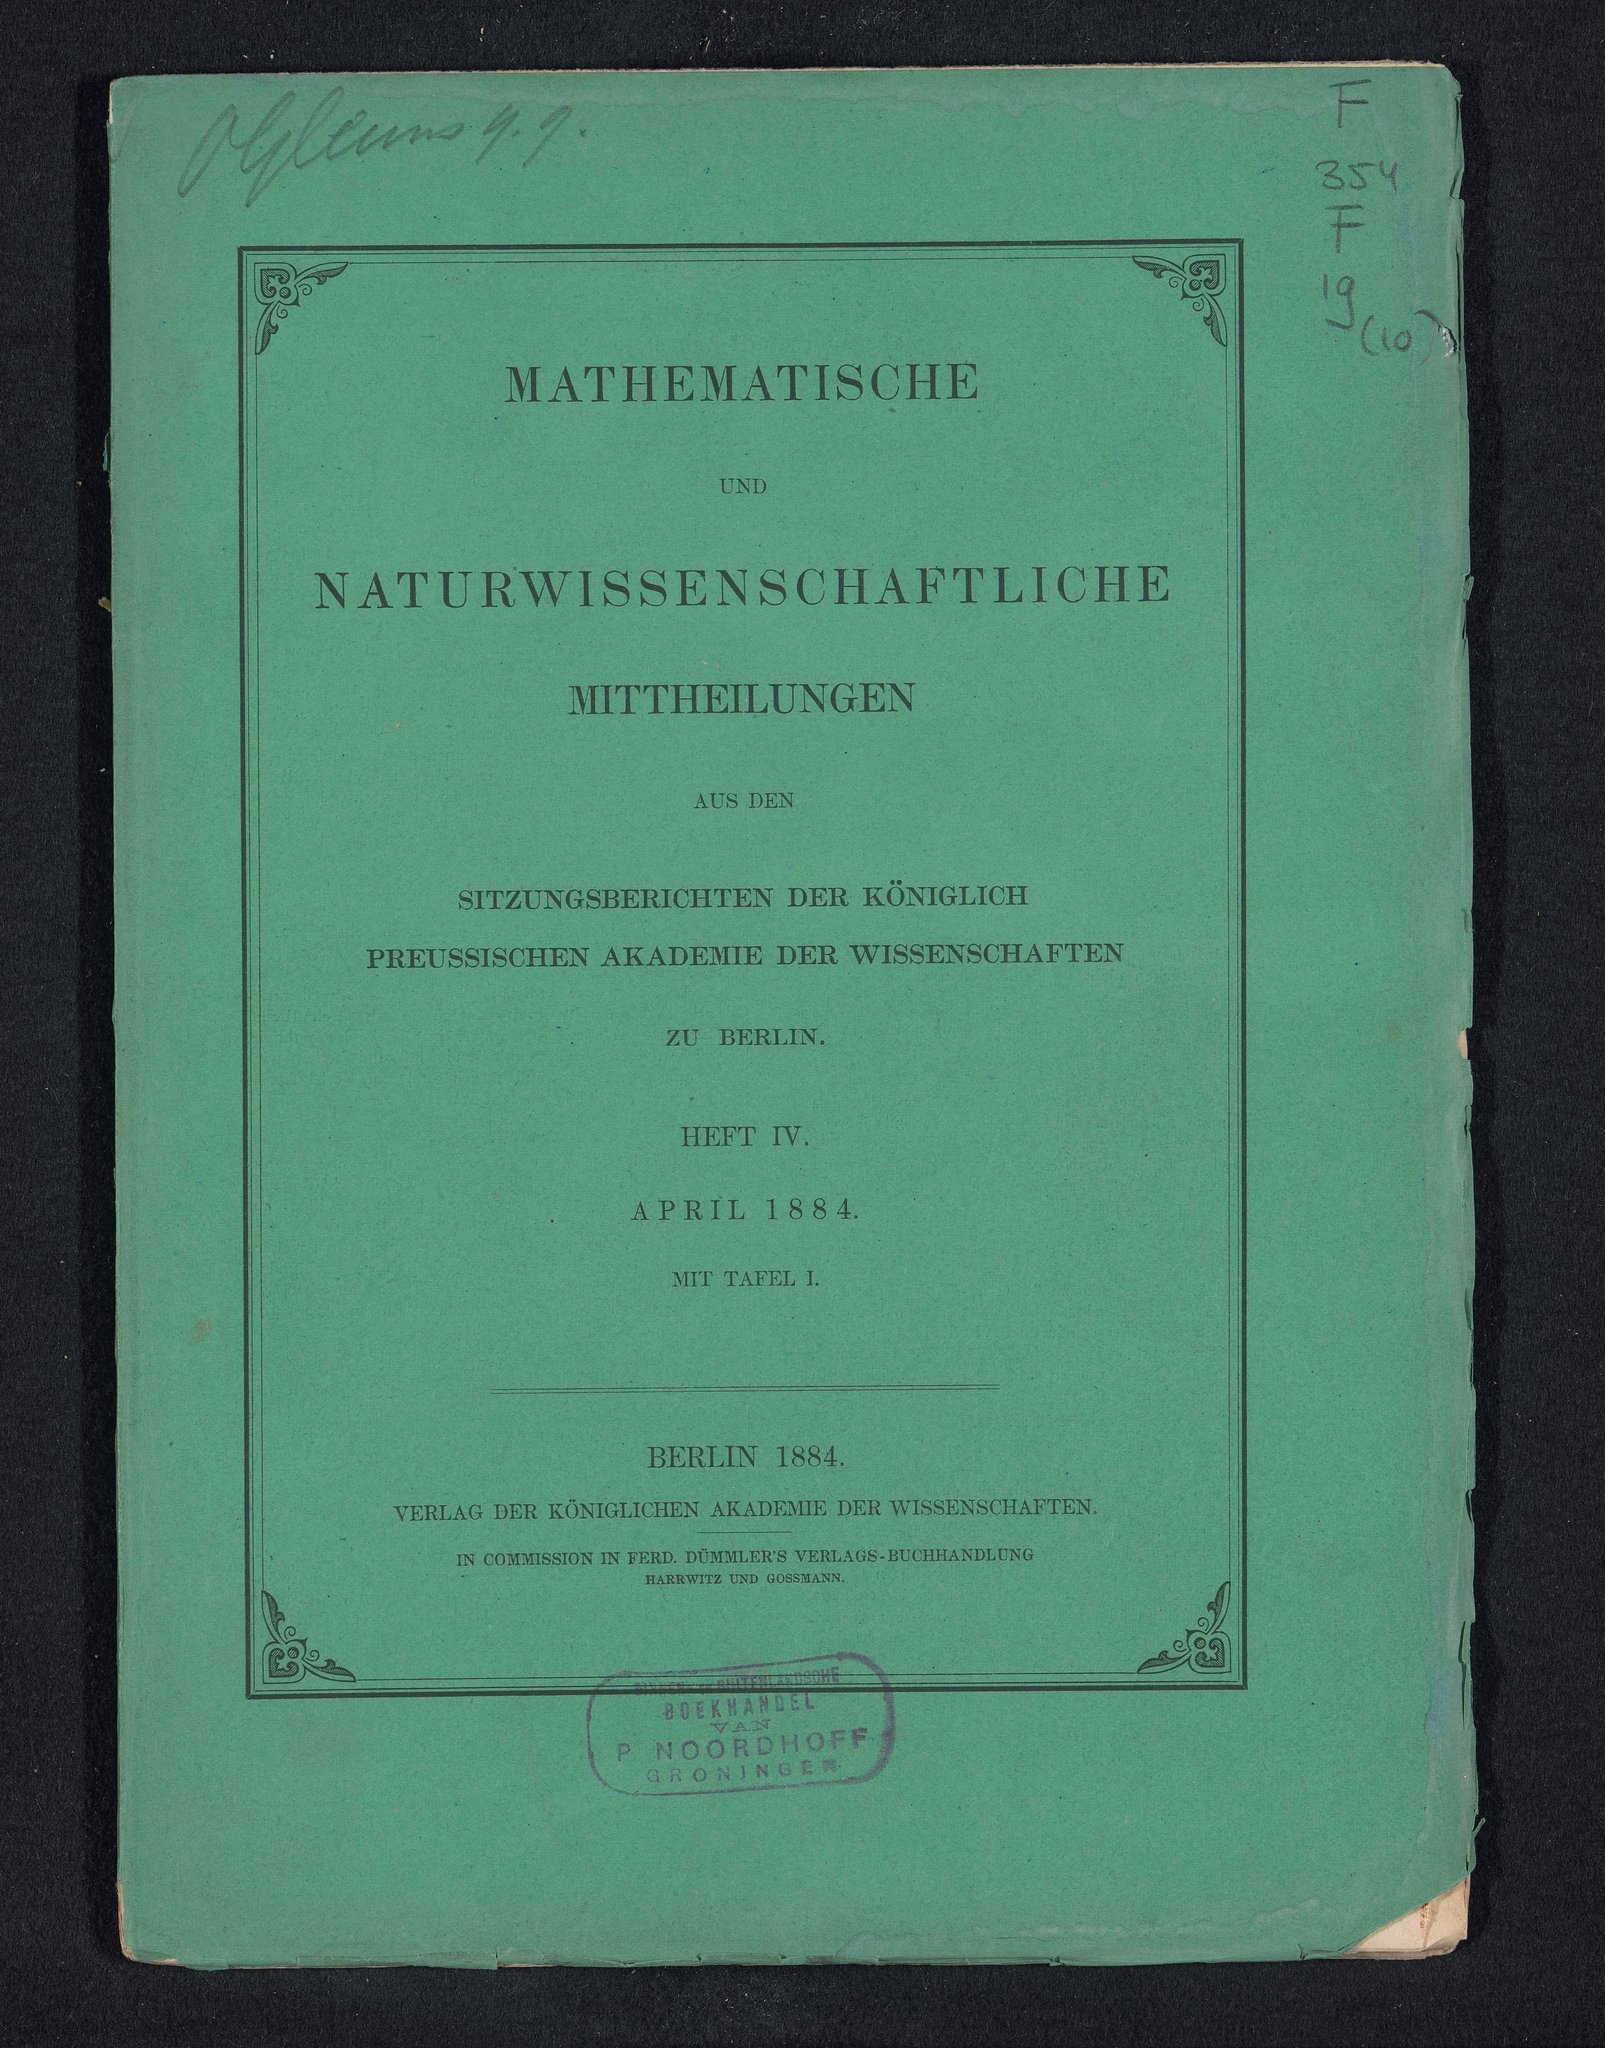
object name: book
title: Mathematische und naturwissenschaftliche Mittheilungen aus den Sitzungsberichten der Königlich Preussischen Akademie der Wissenschaften zu Berlin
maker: p. noordhoff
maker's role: publisher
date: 1884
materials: paper, photographic support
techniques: albumen print, printing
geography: groningen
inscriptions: name: ‘Binnen en Buitenlandsche Boekhandel van P. Noordhoff Groningen’